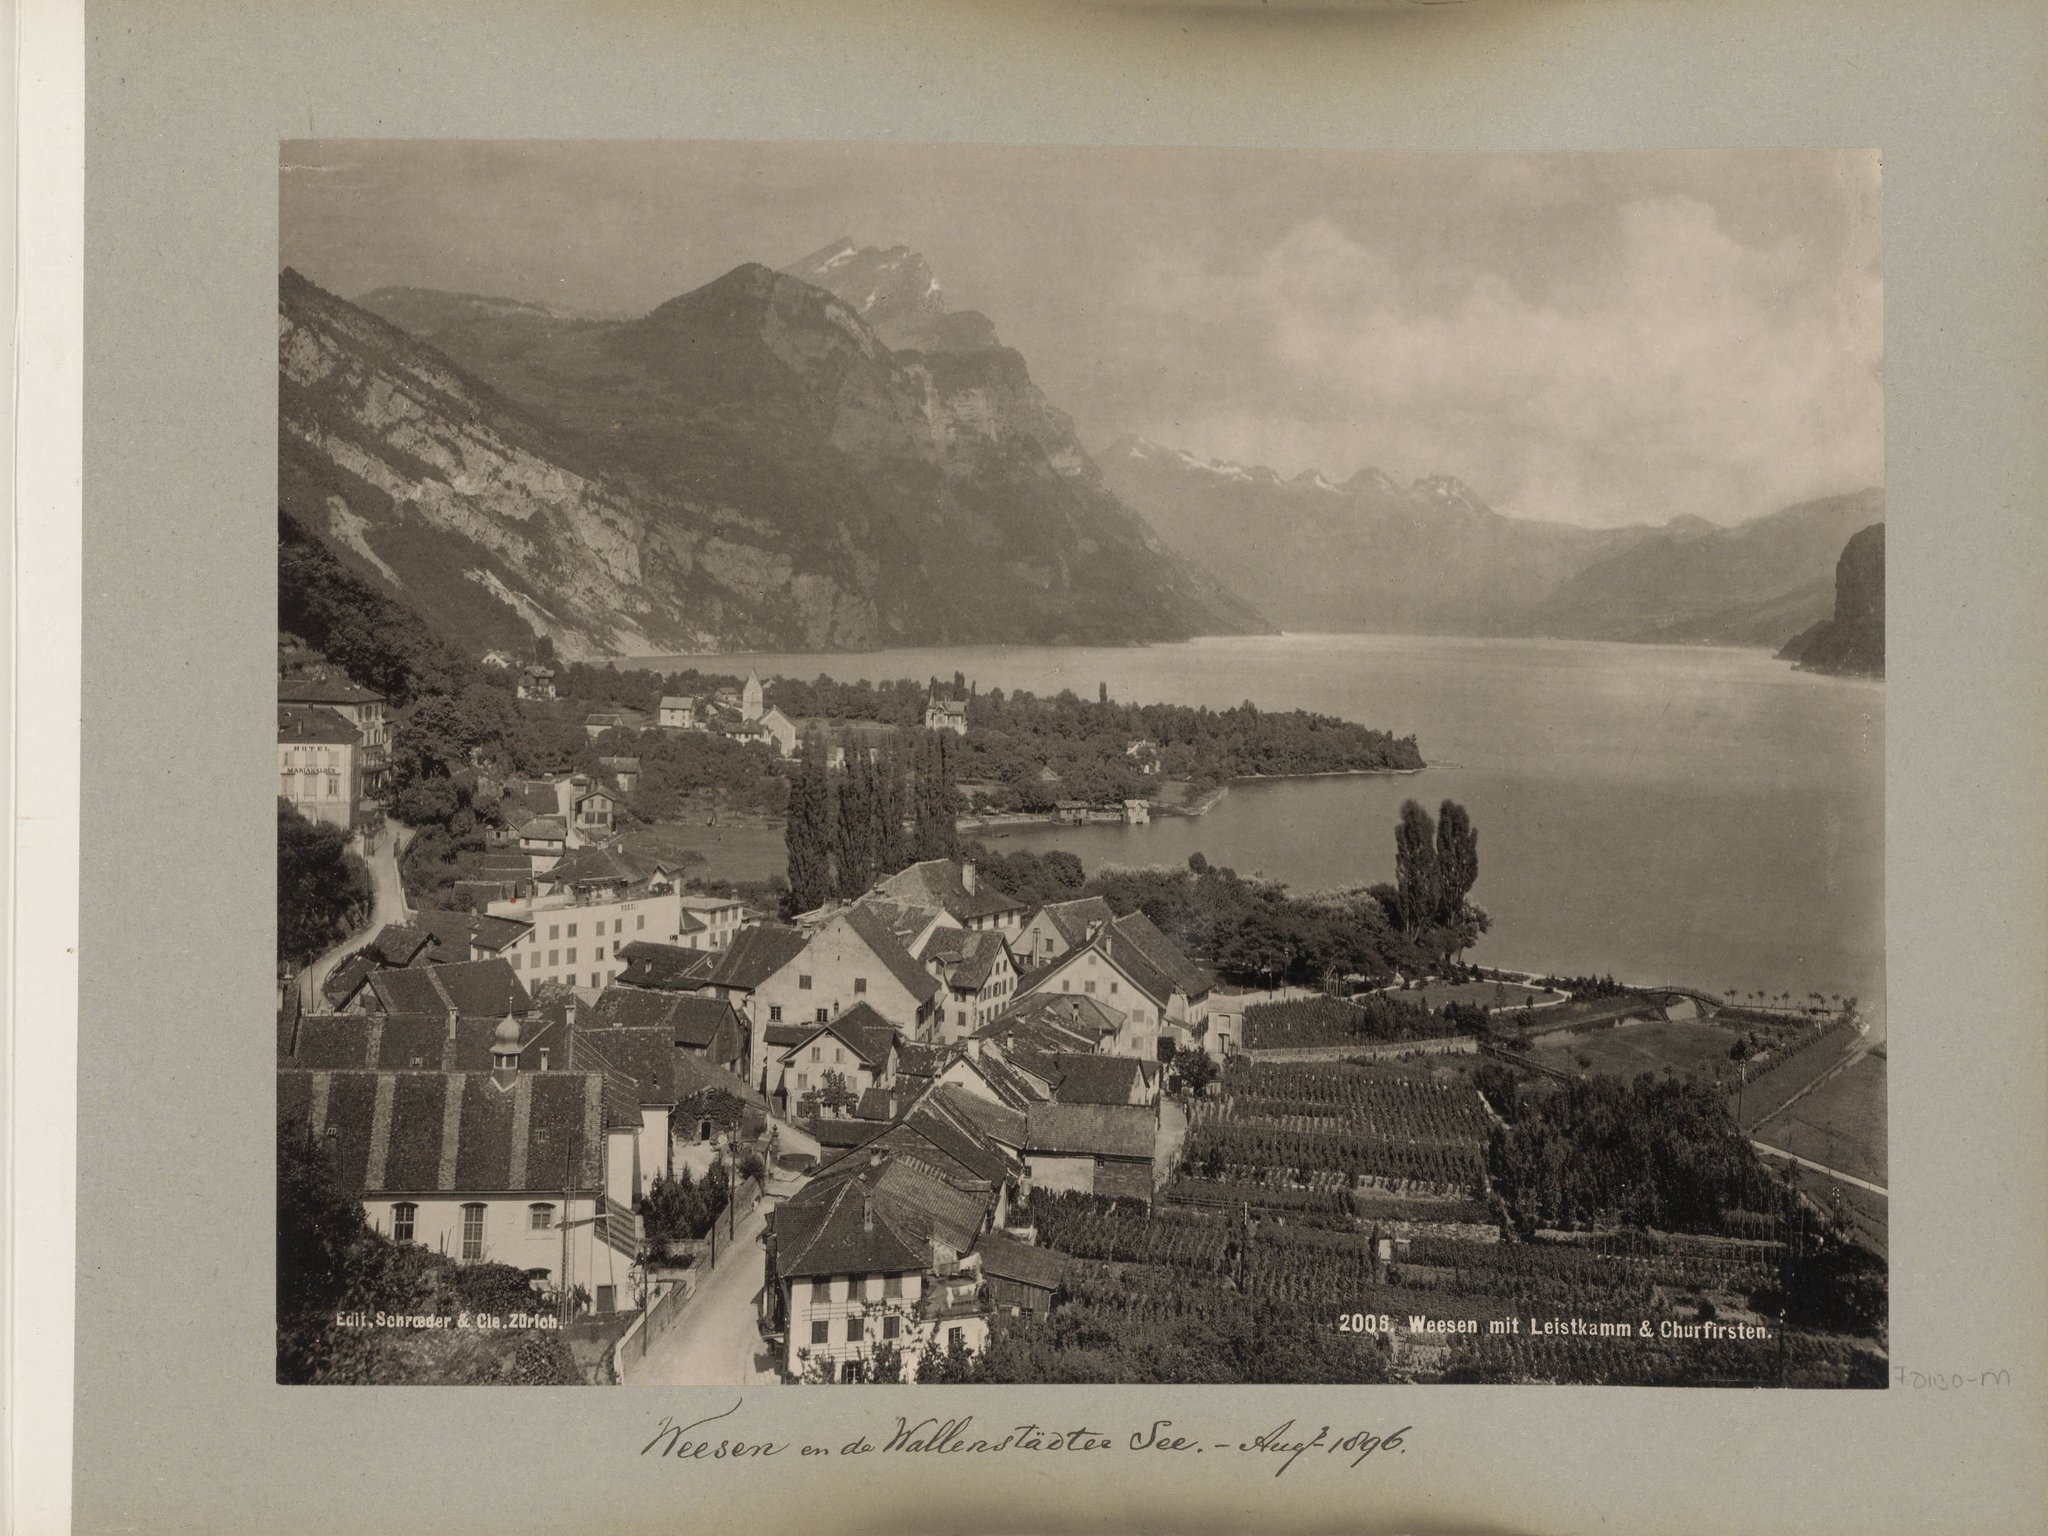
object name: album leaf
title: Weesen mit Leistkamm & Churfirsten.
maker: Anonymous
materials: paper, photographic support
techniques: albumen print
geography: zurich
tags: prospect of village, silhouette of village, mountain-range, snow peaks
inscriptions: negative number: ‘2006’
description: Onderdeel van Reisalbum met foto's van bezienswaardigheden in Frankrijk, Spanje, Italië, Duitsland, Zwitserland en Oostenrijk.